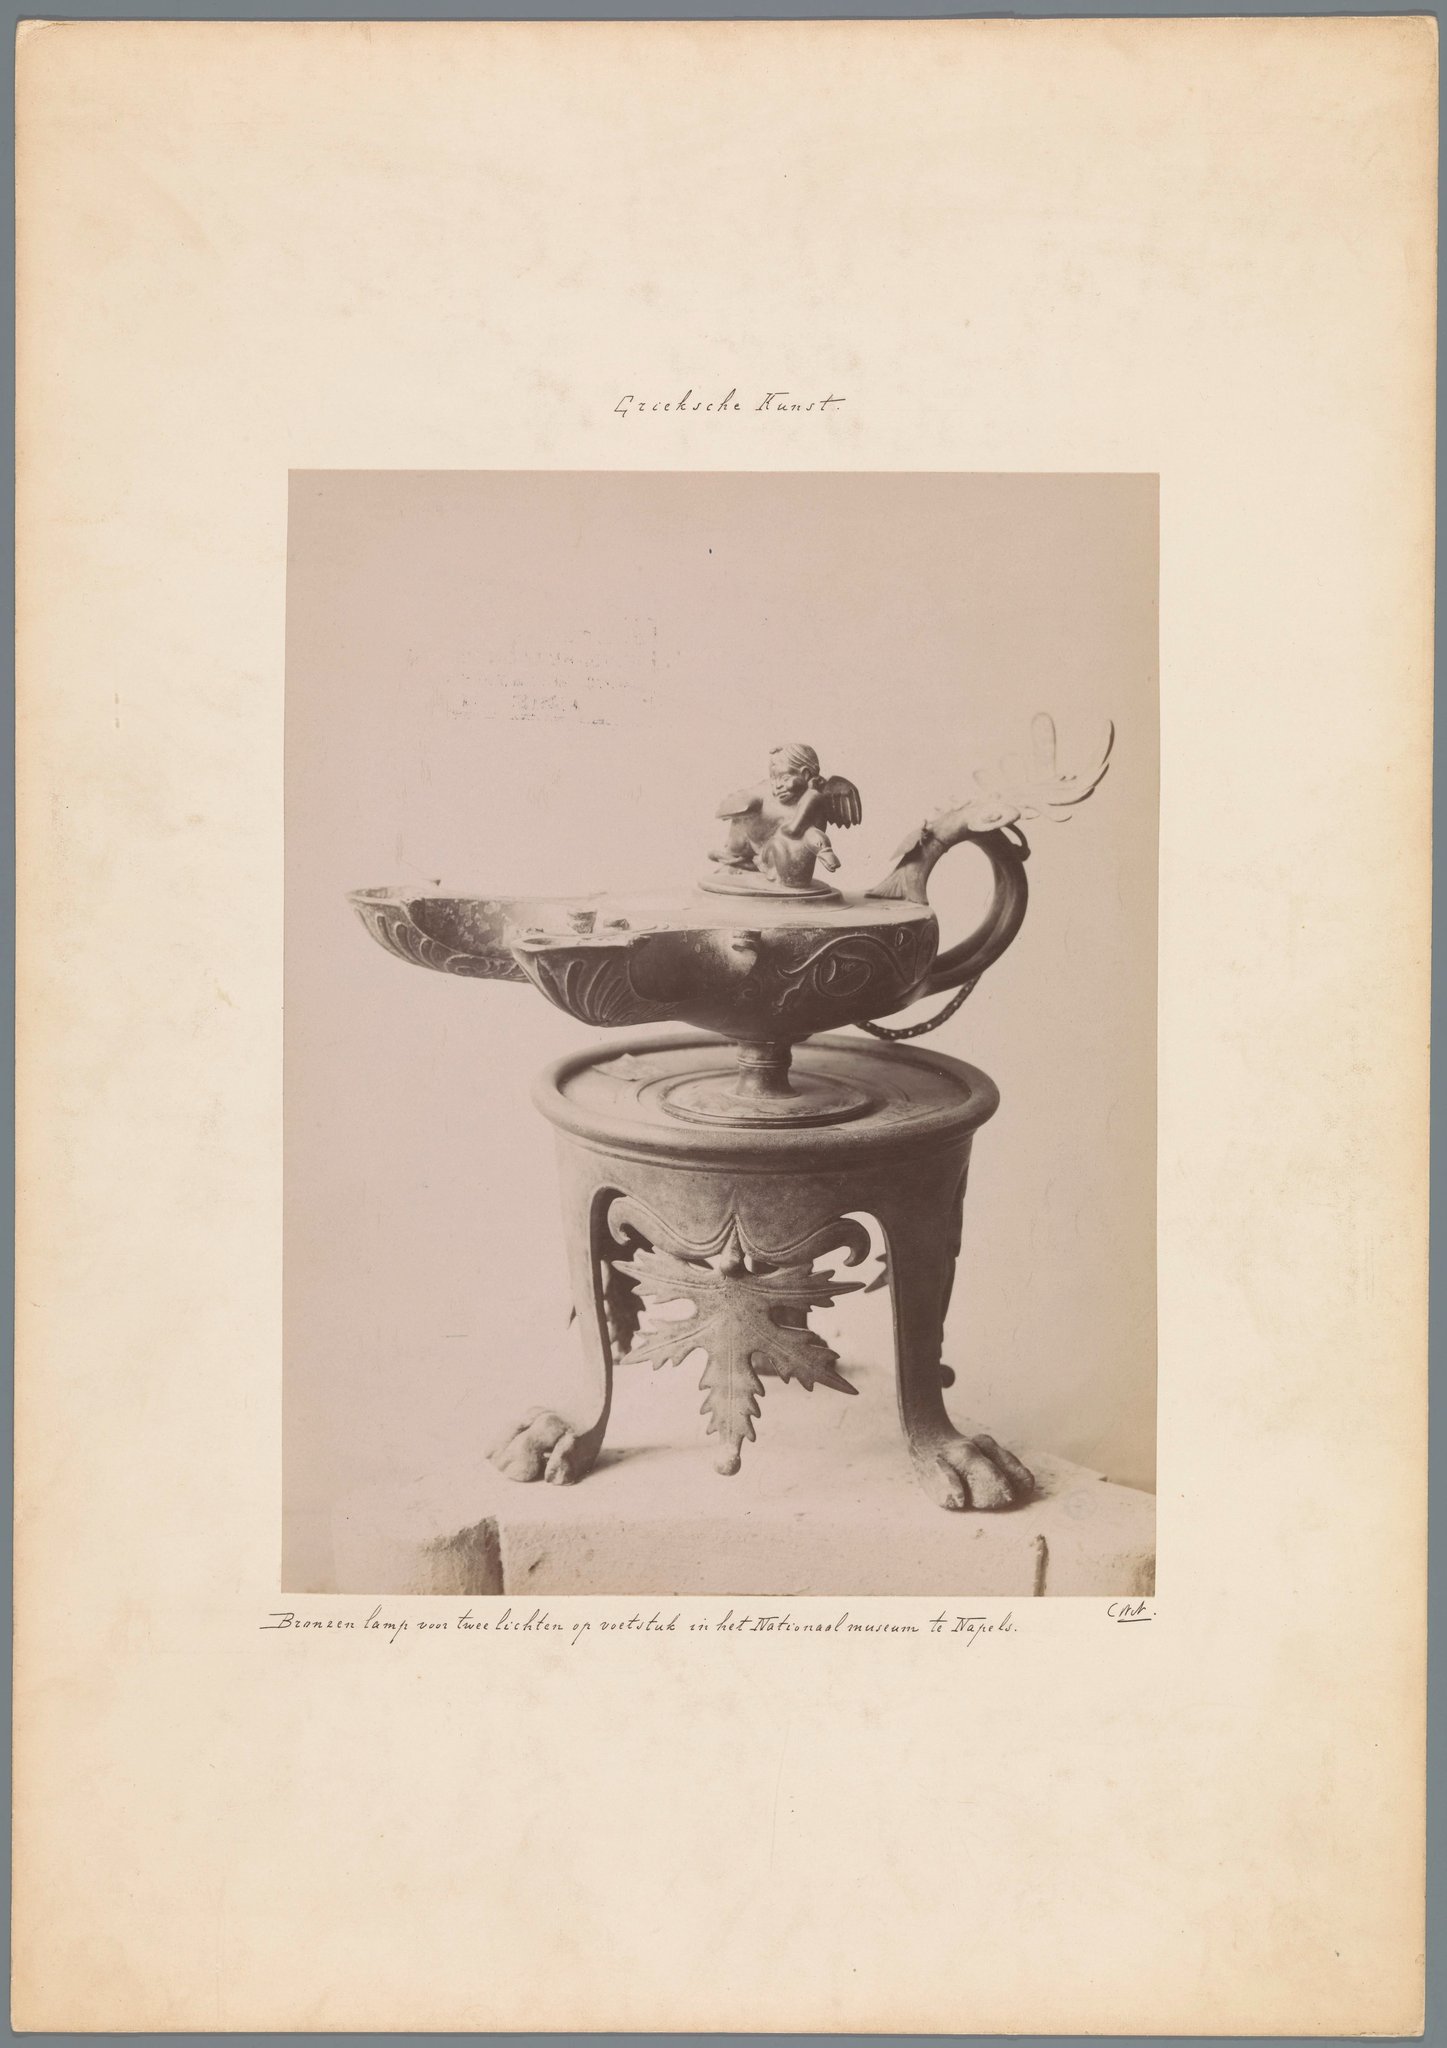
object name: photograph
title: Bronzen olielamp op een piëdestal in het Museo Nazionale te Napels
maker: Anonymous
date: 1875-1900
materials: cardboard, photographic support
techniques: albumen print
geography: naples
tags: oil-lamp, cupids: 'amores', 'amoretti', 'putti'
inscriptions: inscription: ‘Grieksche Kunst. Bronzen lamp voor twee lichten op voetstuk in het Nationaal museum te Napels.’, collector's mark: ‘KUNSTNIJVERHEIDSCHOOL QUELLINUS AMSTERDAM FRANS HALSSTRAAT 14.’, inscription: ‘CWN.’, collector's mark: ‘INSTITUUT VOOR KUNST- NIJVERHEIDSONDERWIJS GABRIËL METSUSTRAAT No. 16. AMSTERDAM’